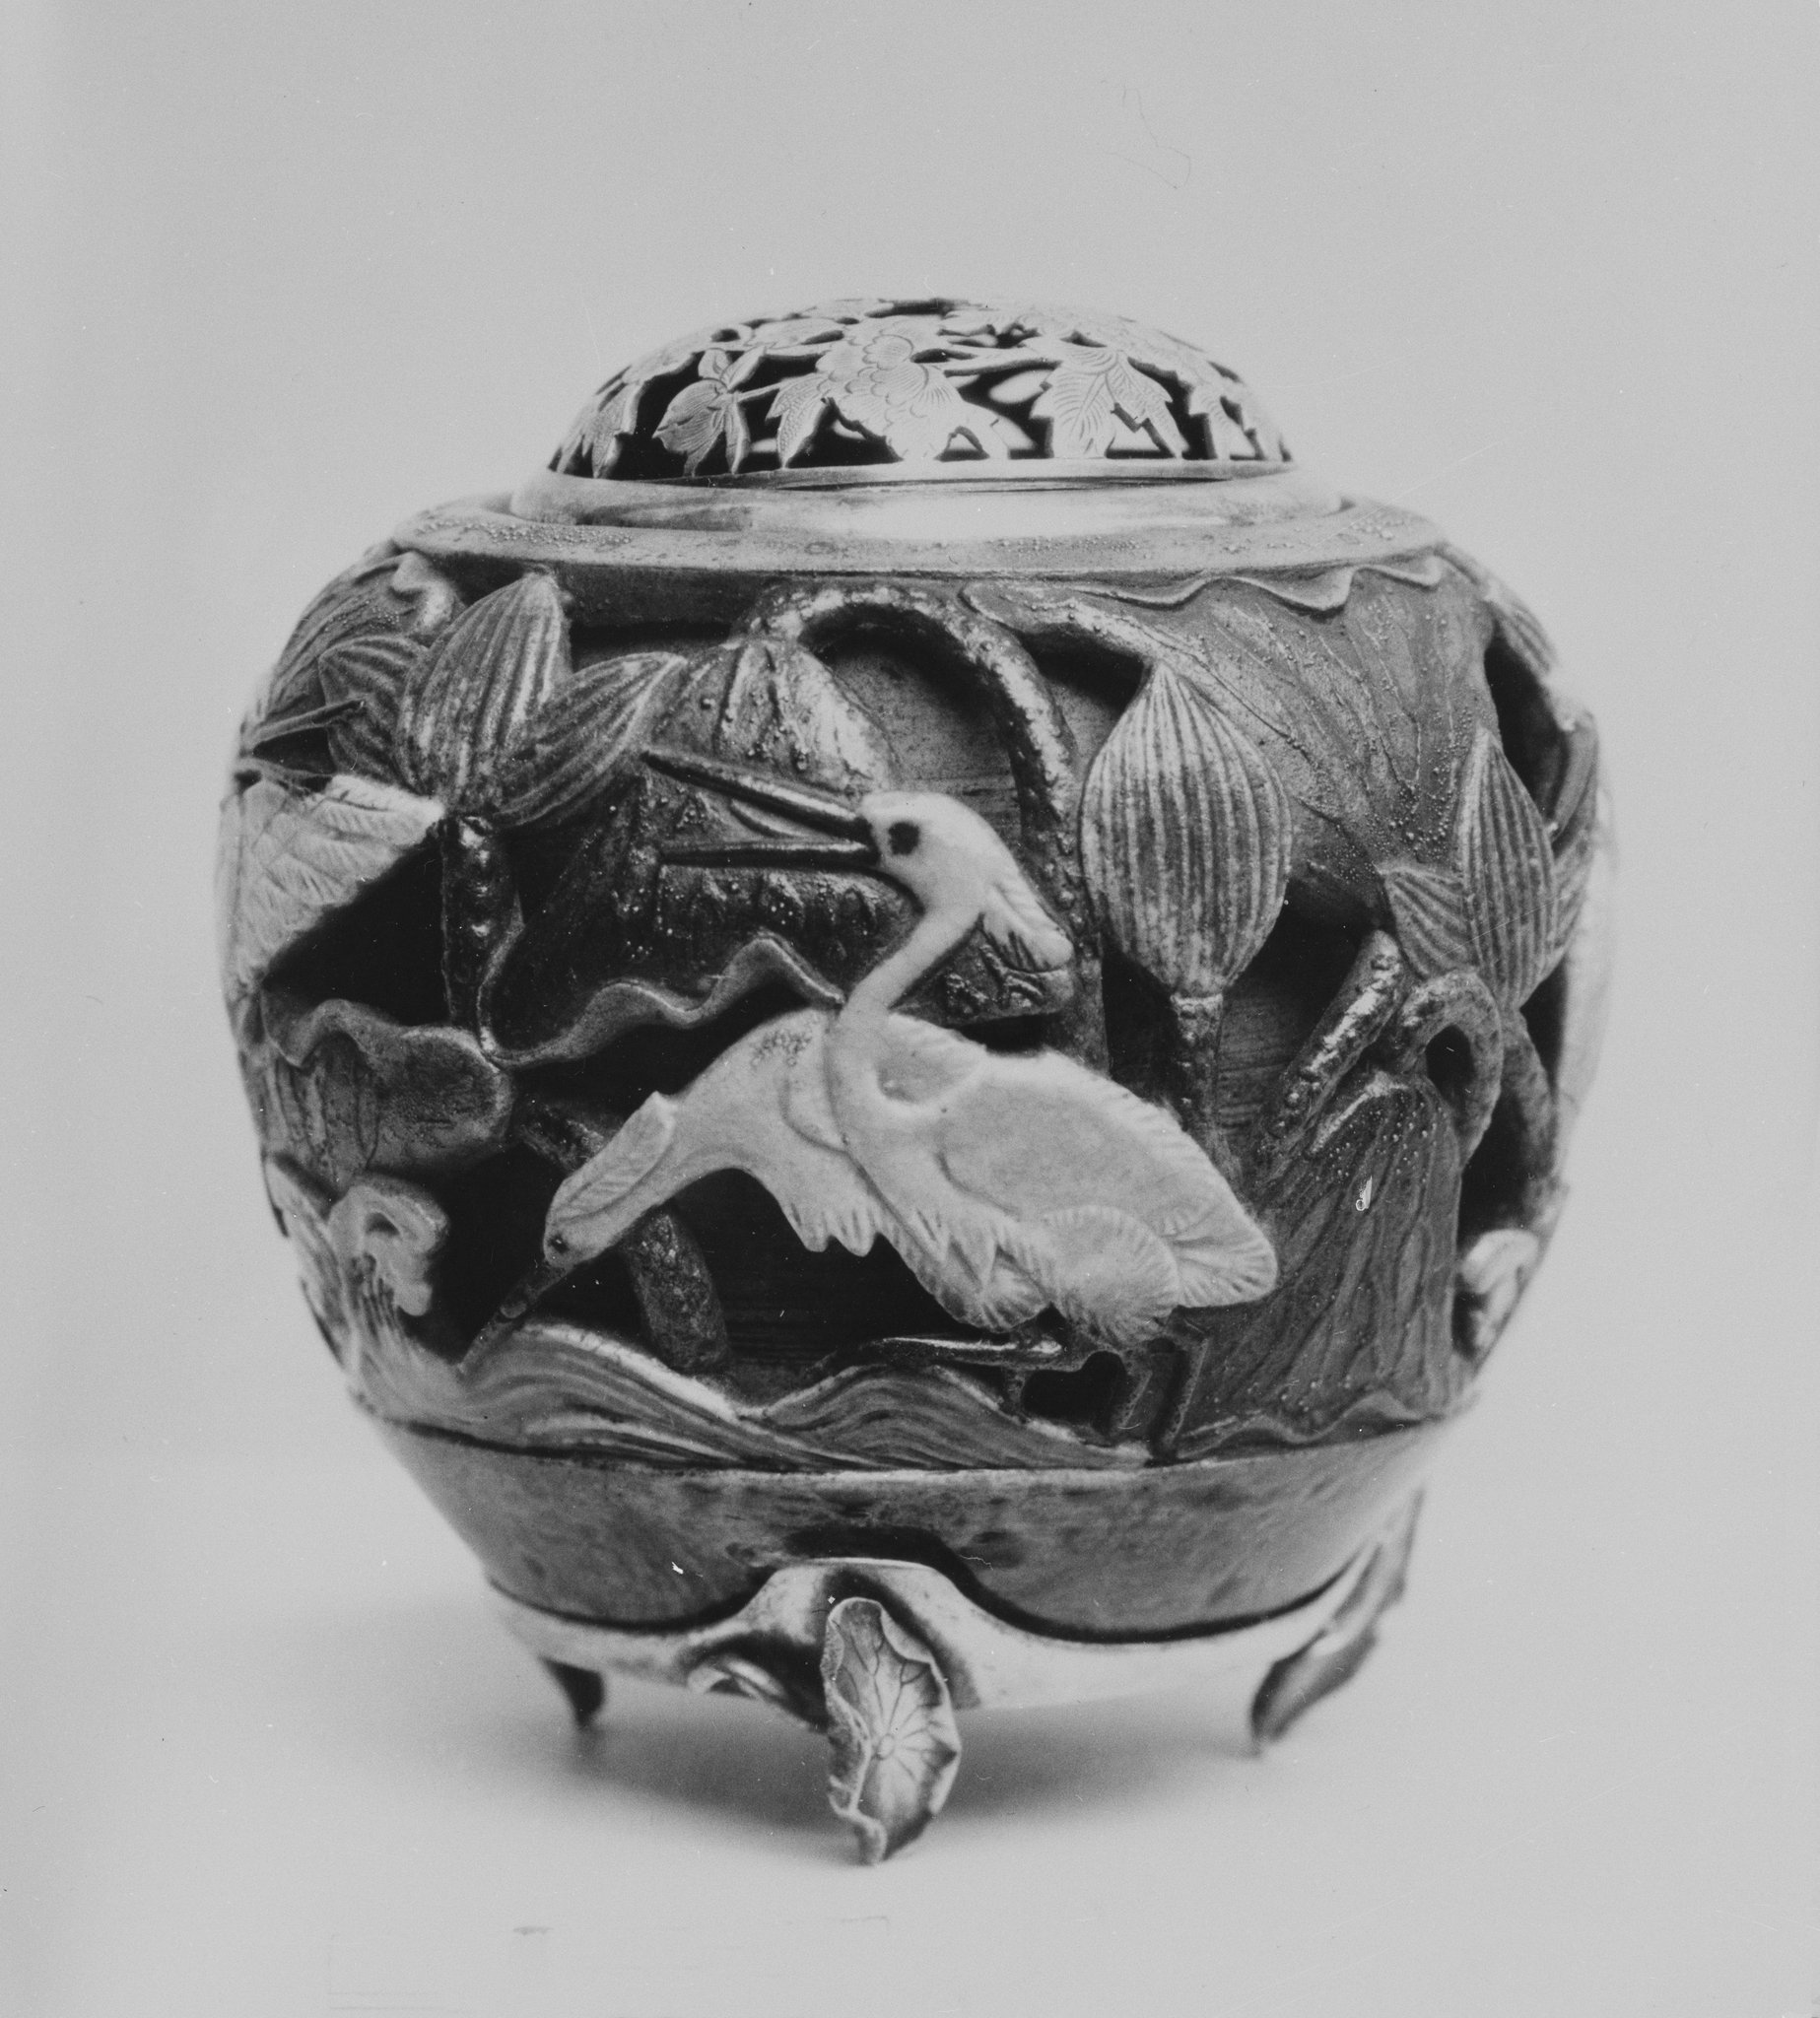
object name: incense burner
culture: japanese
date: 1780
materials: silver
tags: birds